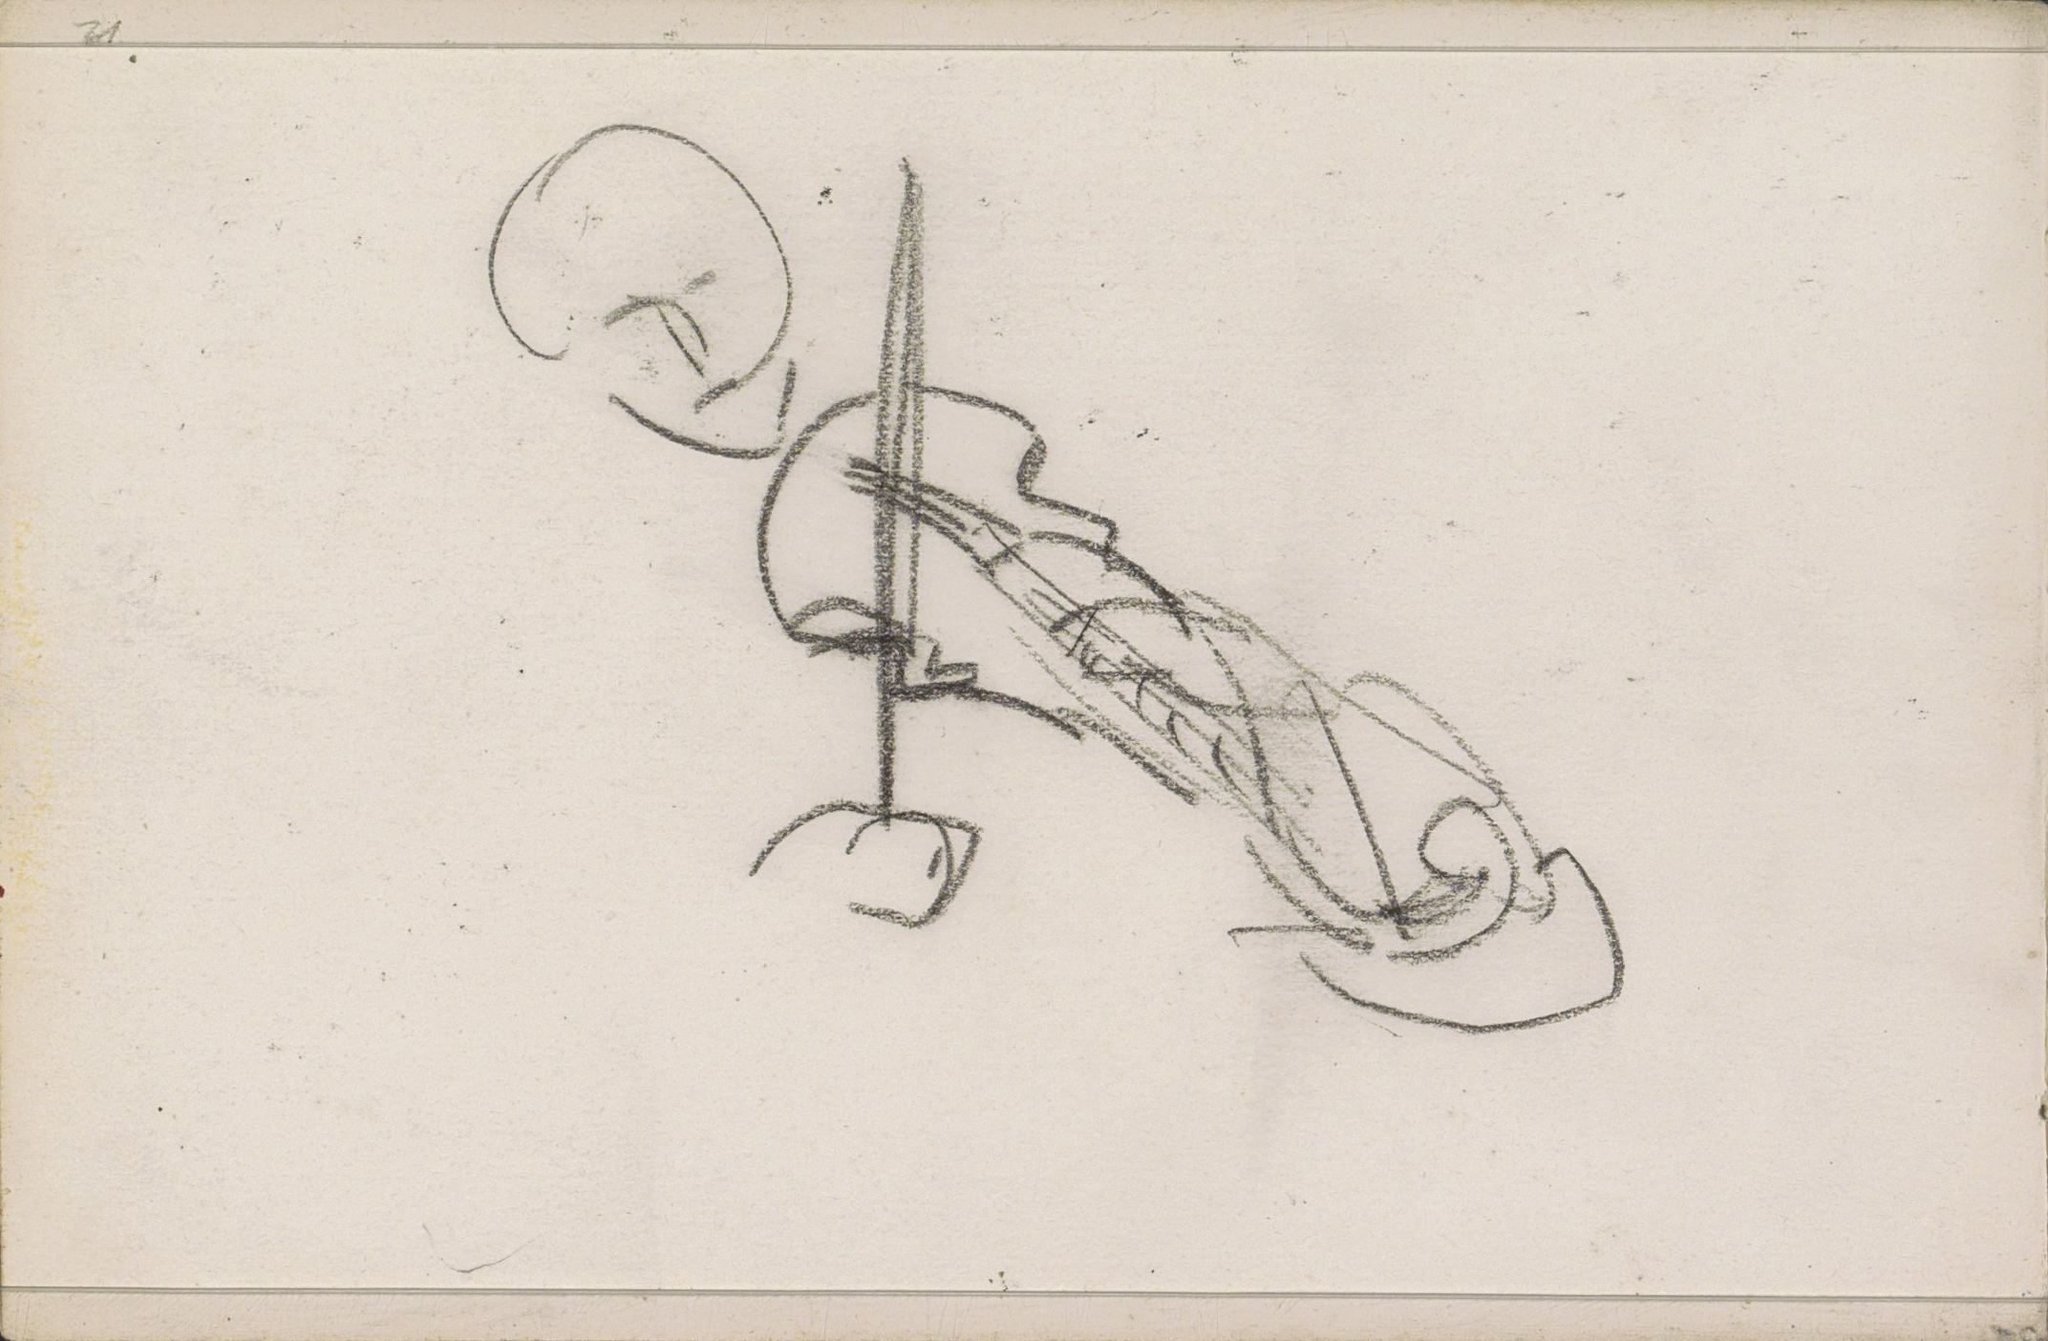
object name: sketchbook leaf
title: Violist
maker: isaac israels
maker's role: draughtsman, painter, print maker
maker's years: 1865-1934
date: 1875-1934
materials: chalk, paper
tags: violin, fiddle (+ artist at work)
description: Blad 9 verso uit schetsboek LIII met 10 bladen.